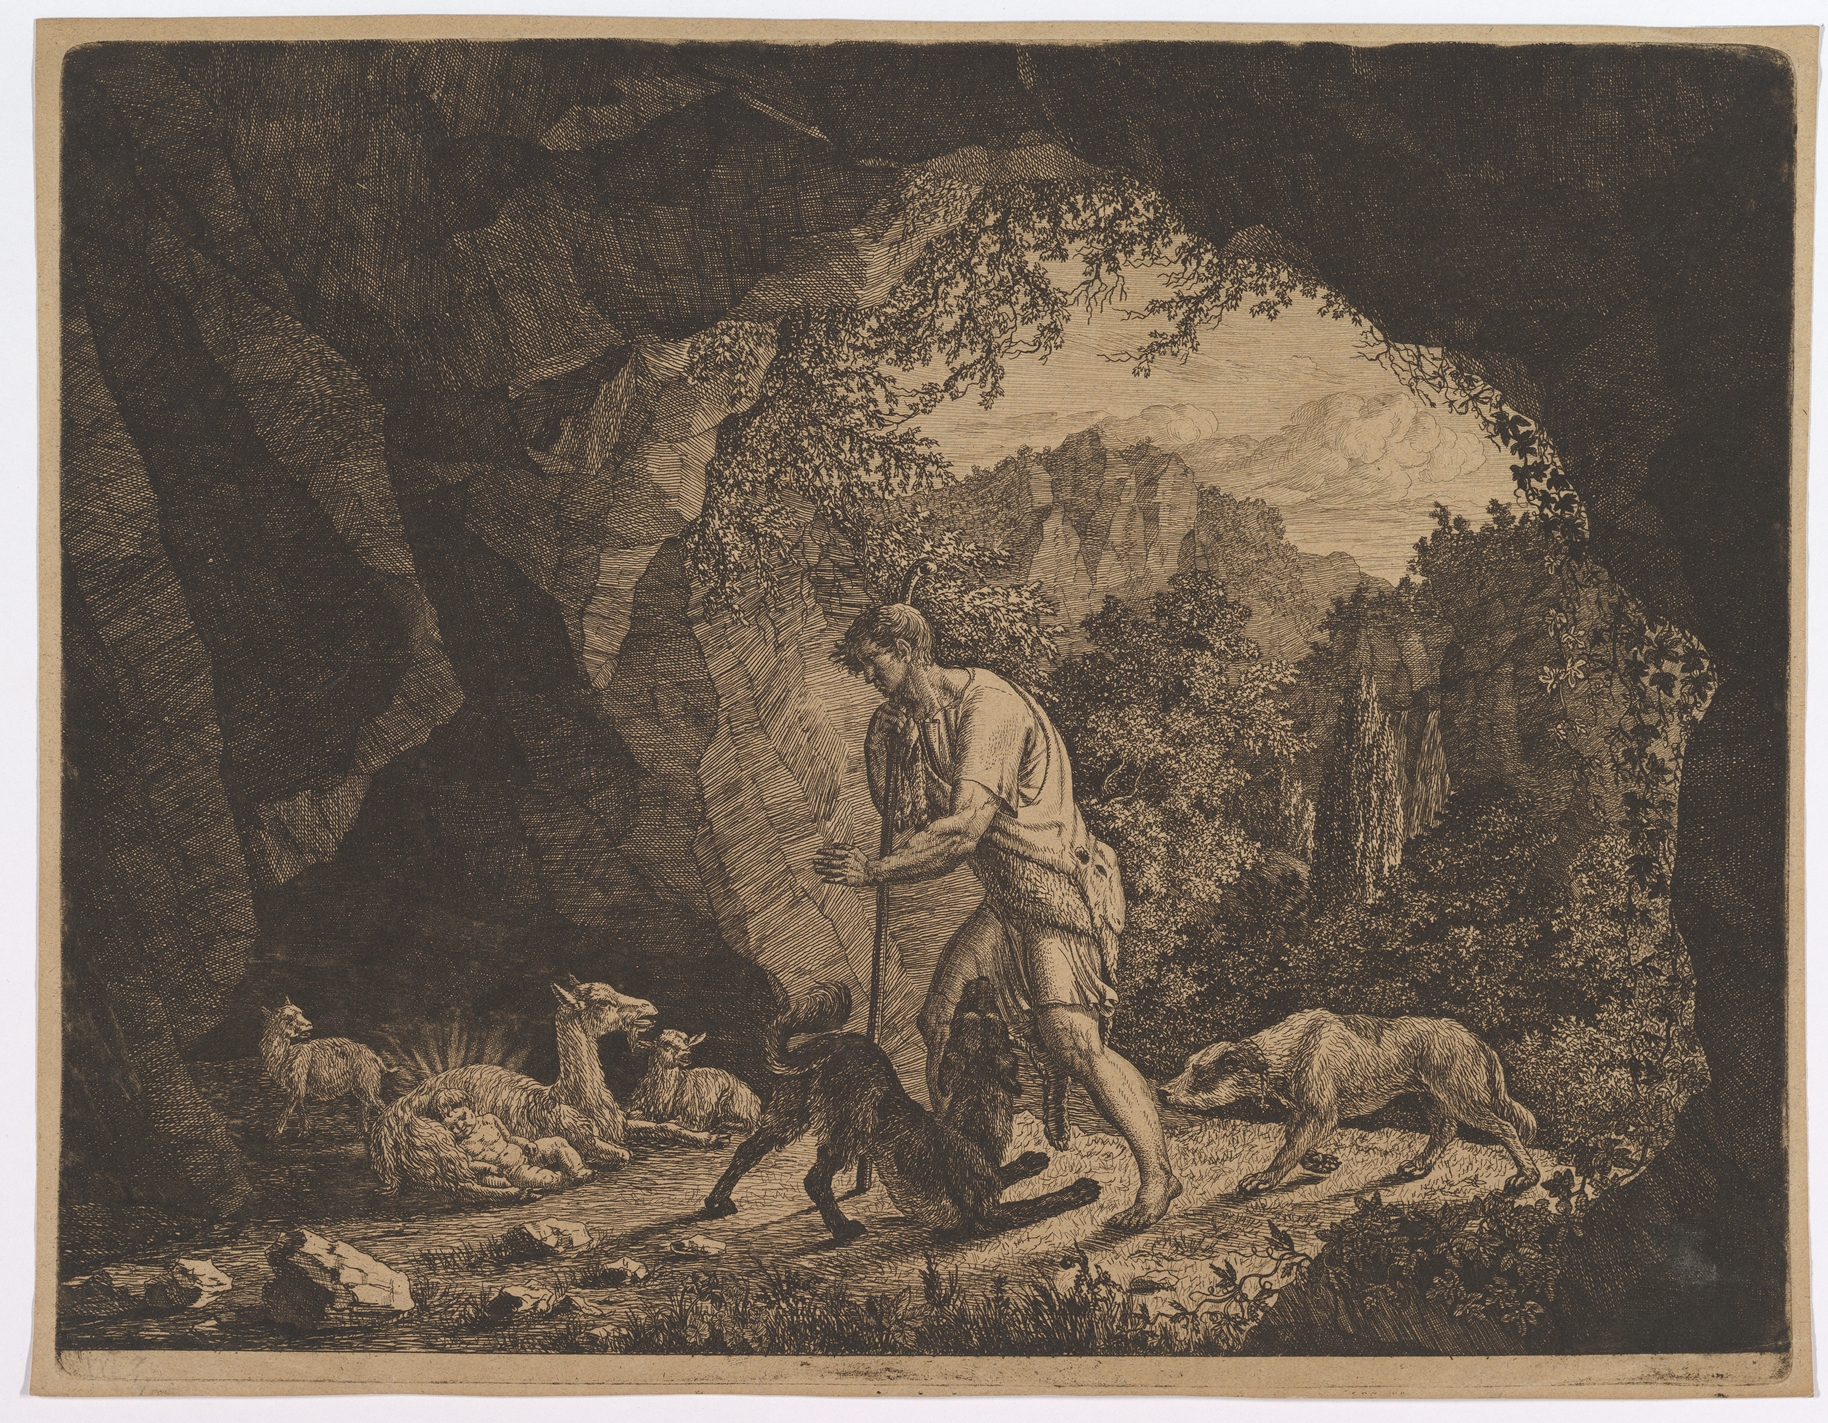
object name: print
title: The Shepherd Finding Romulus near the Goat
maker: carl baron von vittinghoff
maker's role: artist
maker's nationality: german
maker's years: 1772-1826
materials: paper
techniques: etching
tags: goats,shepherds